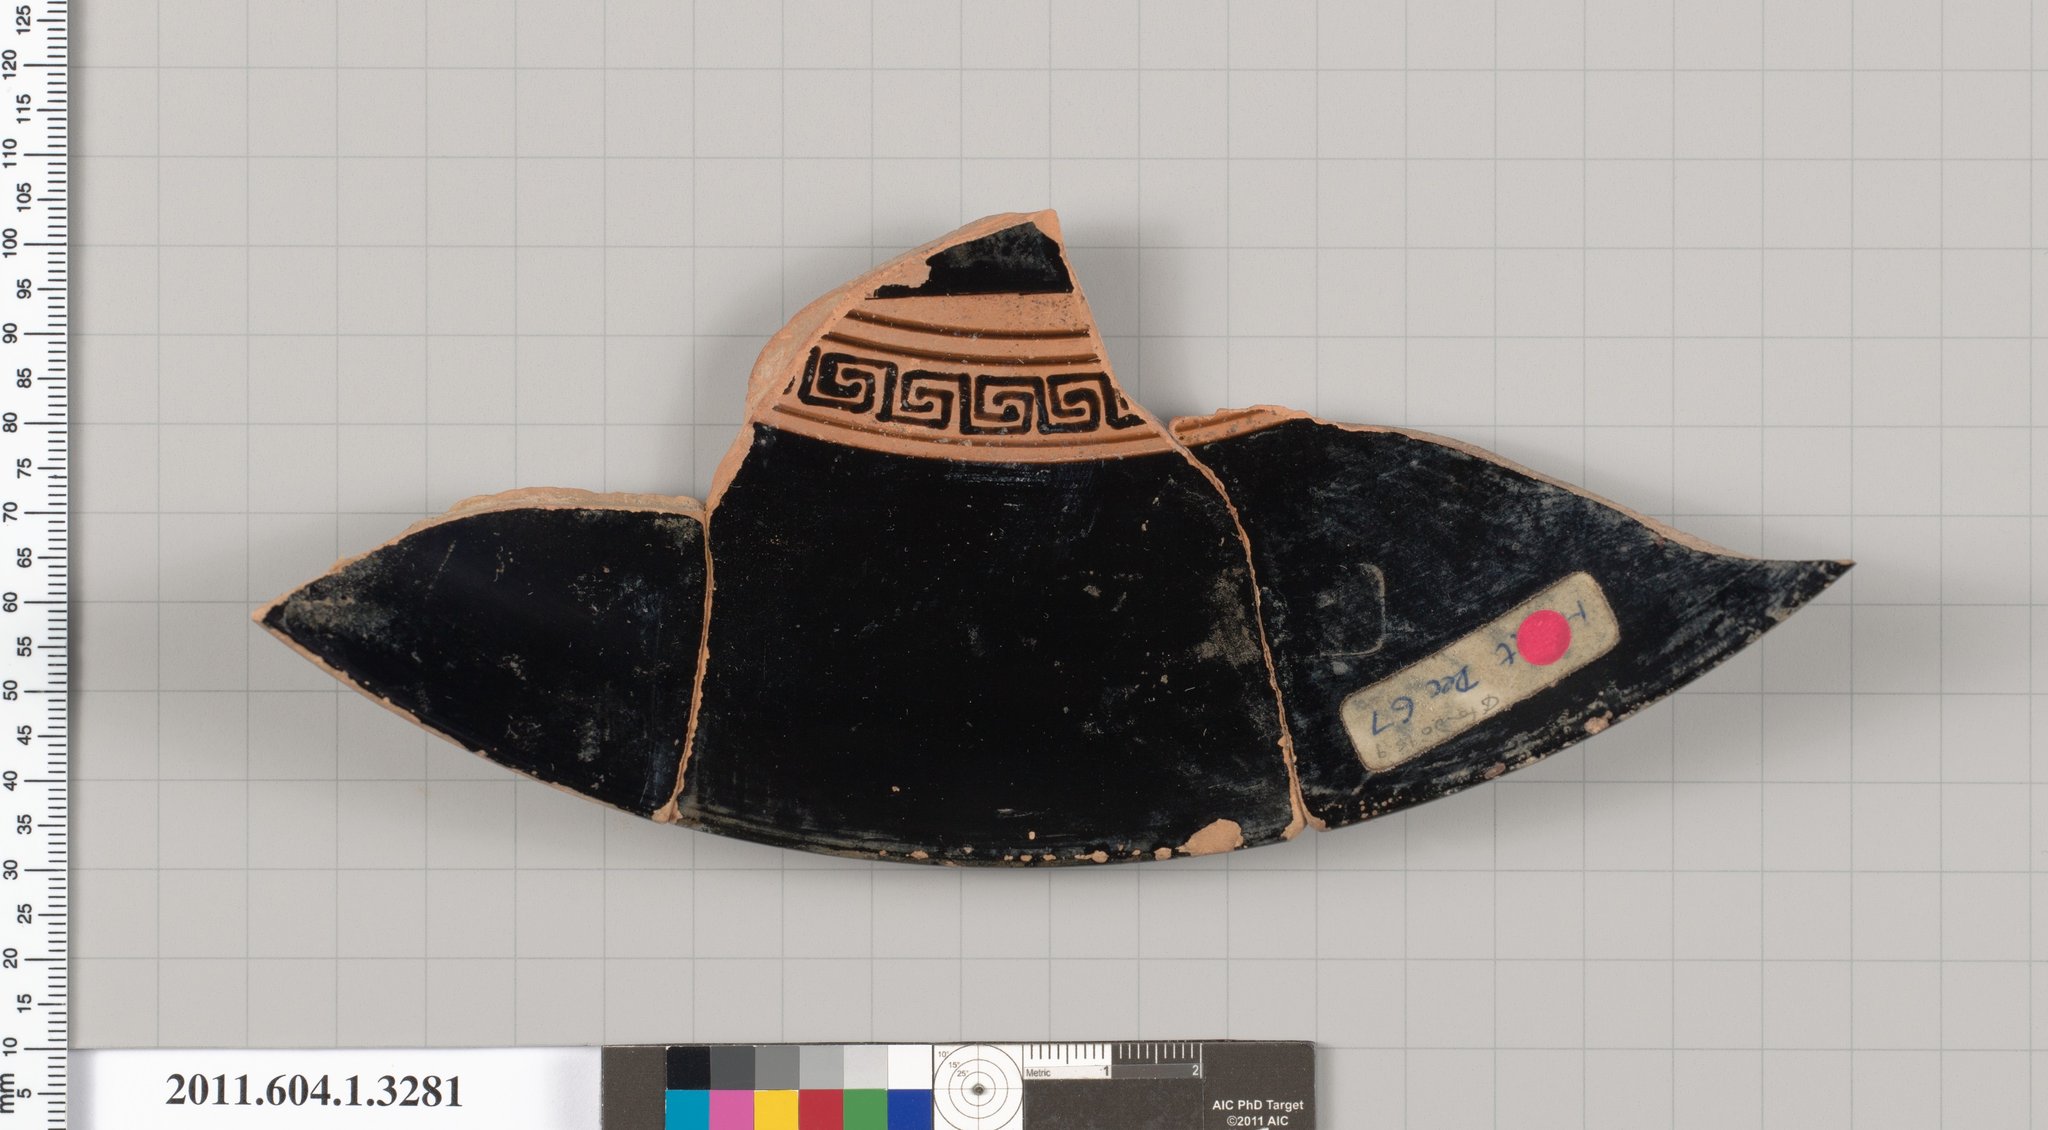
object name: kylix fragment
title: Terracotta fragment of a kylix (drinking cup)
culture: greek, attic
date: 500-470 BCE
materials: terracotta